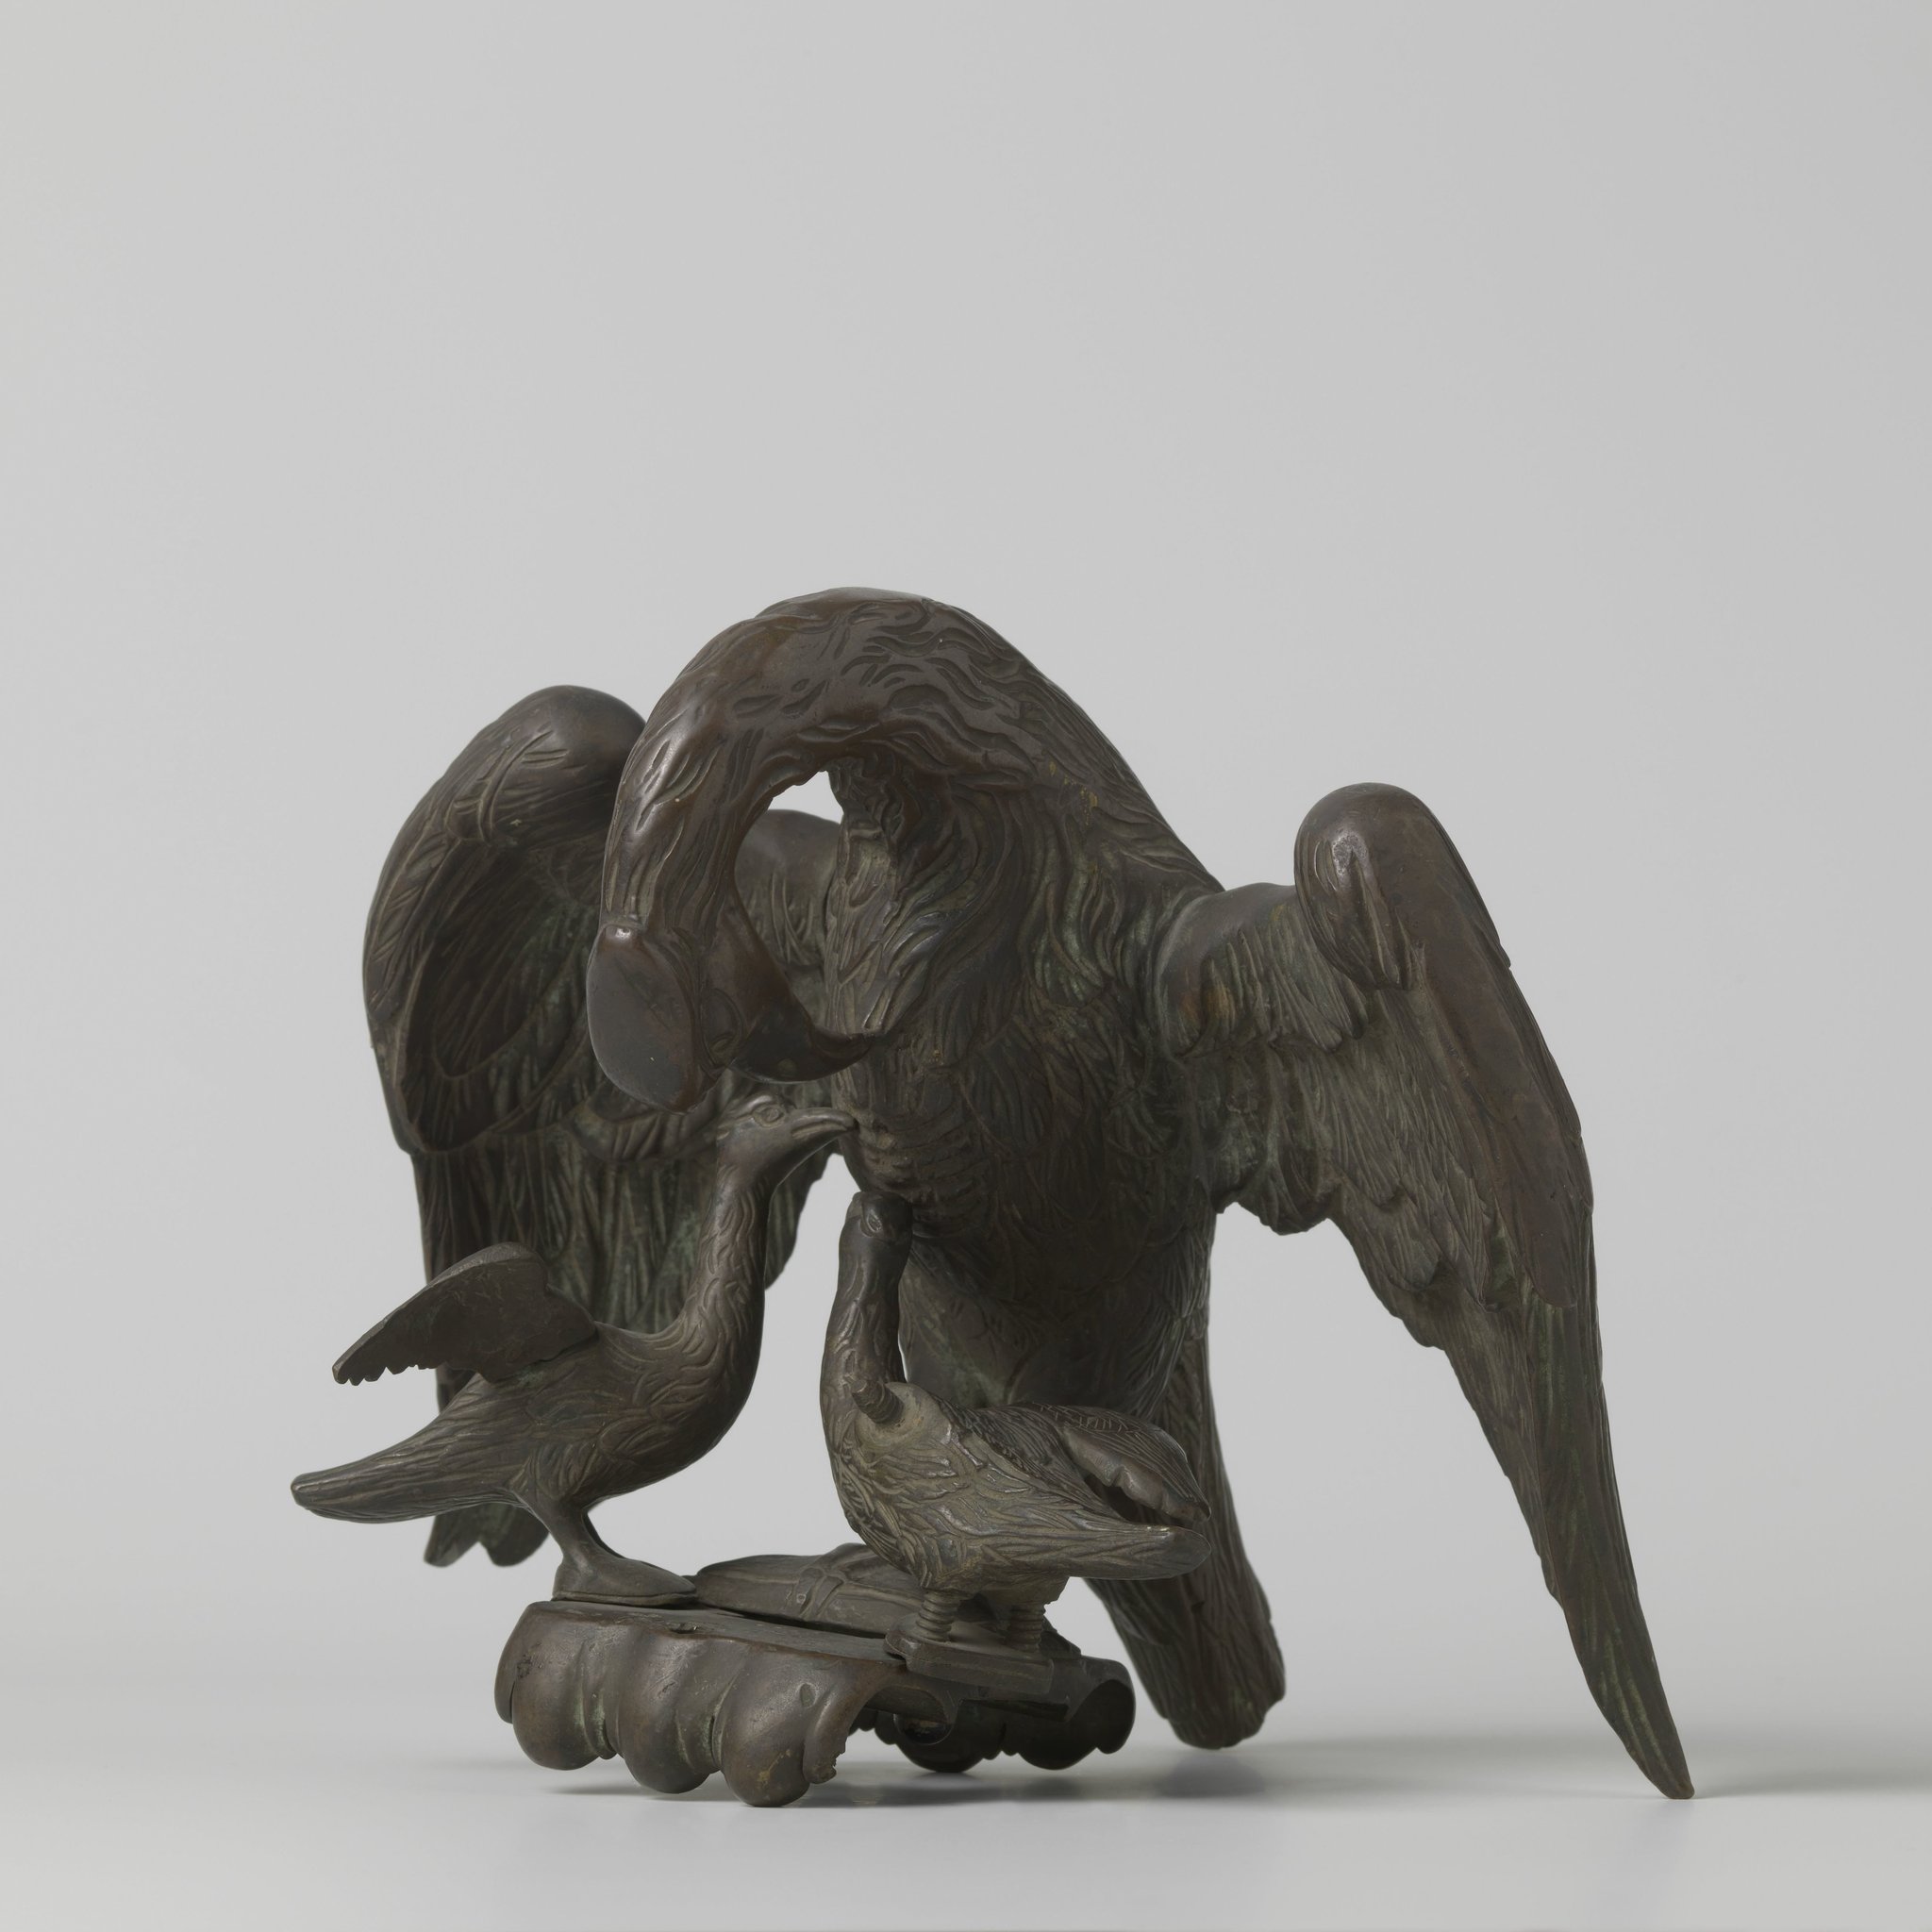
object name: figure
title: Pelikanenjong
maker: Anonymous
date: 1750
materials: brass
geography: netherlands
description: Beeld van een pelikanenjong. Betreft een groep van pelikaan met twee jongen, zie ook BK-NM-9443-a en b. De groep symboliseert het Christelijk geloof.